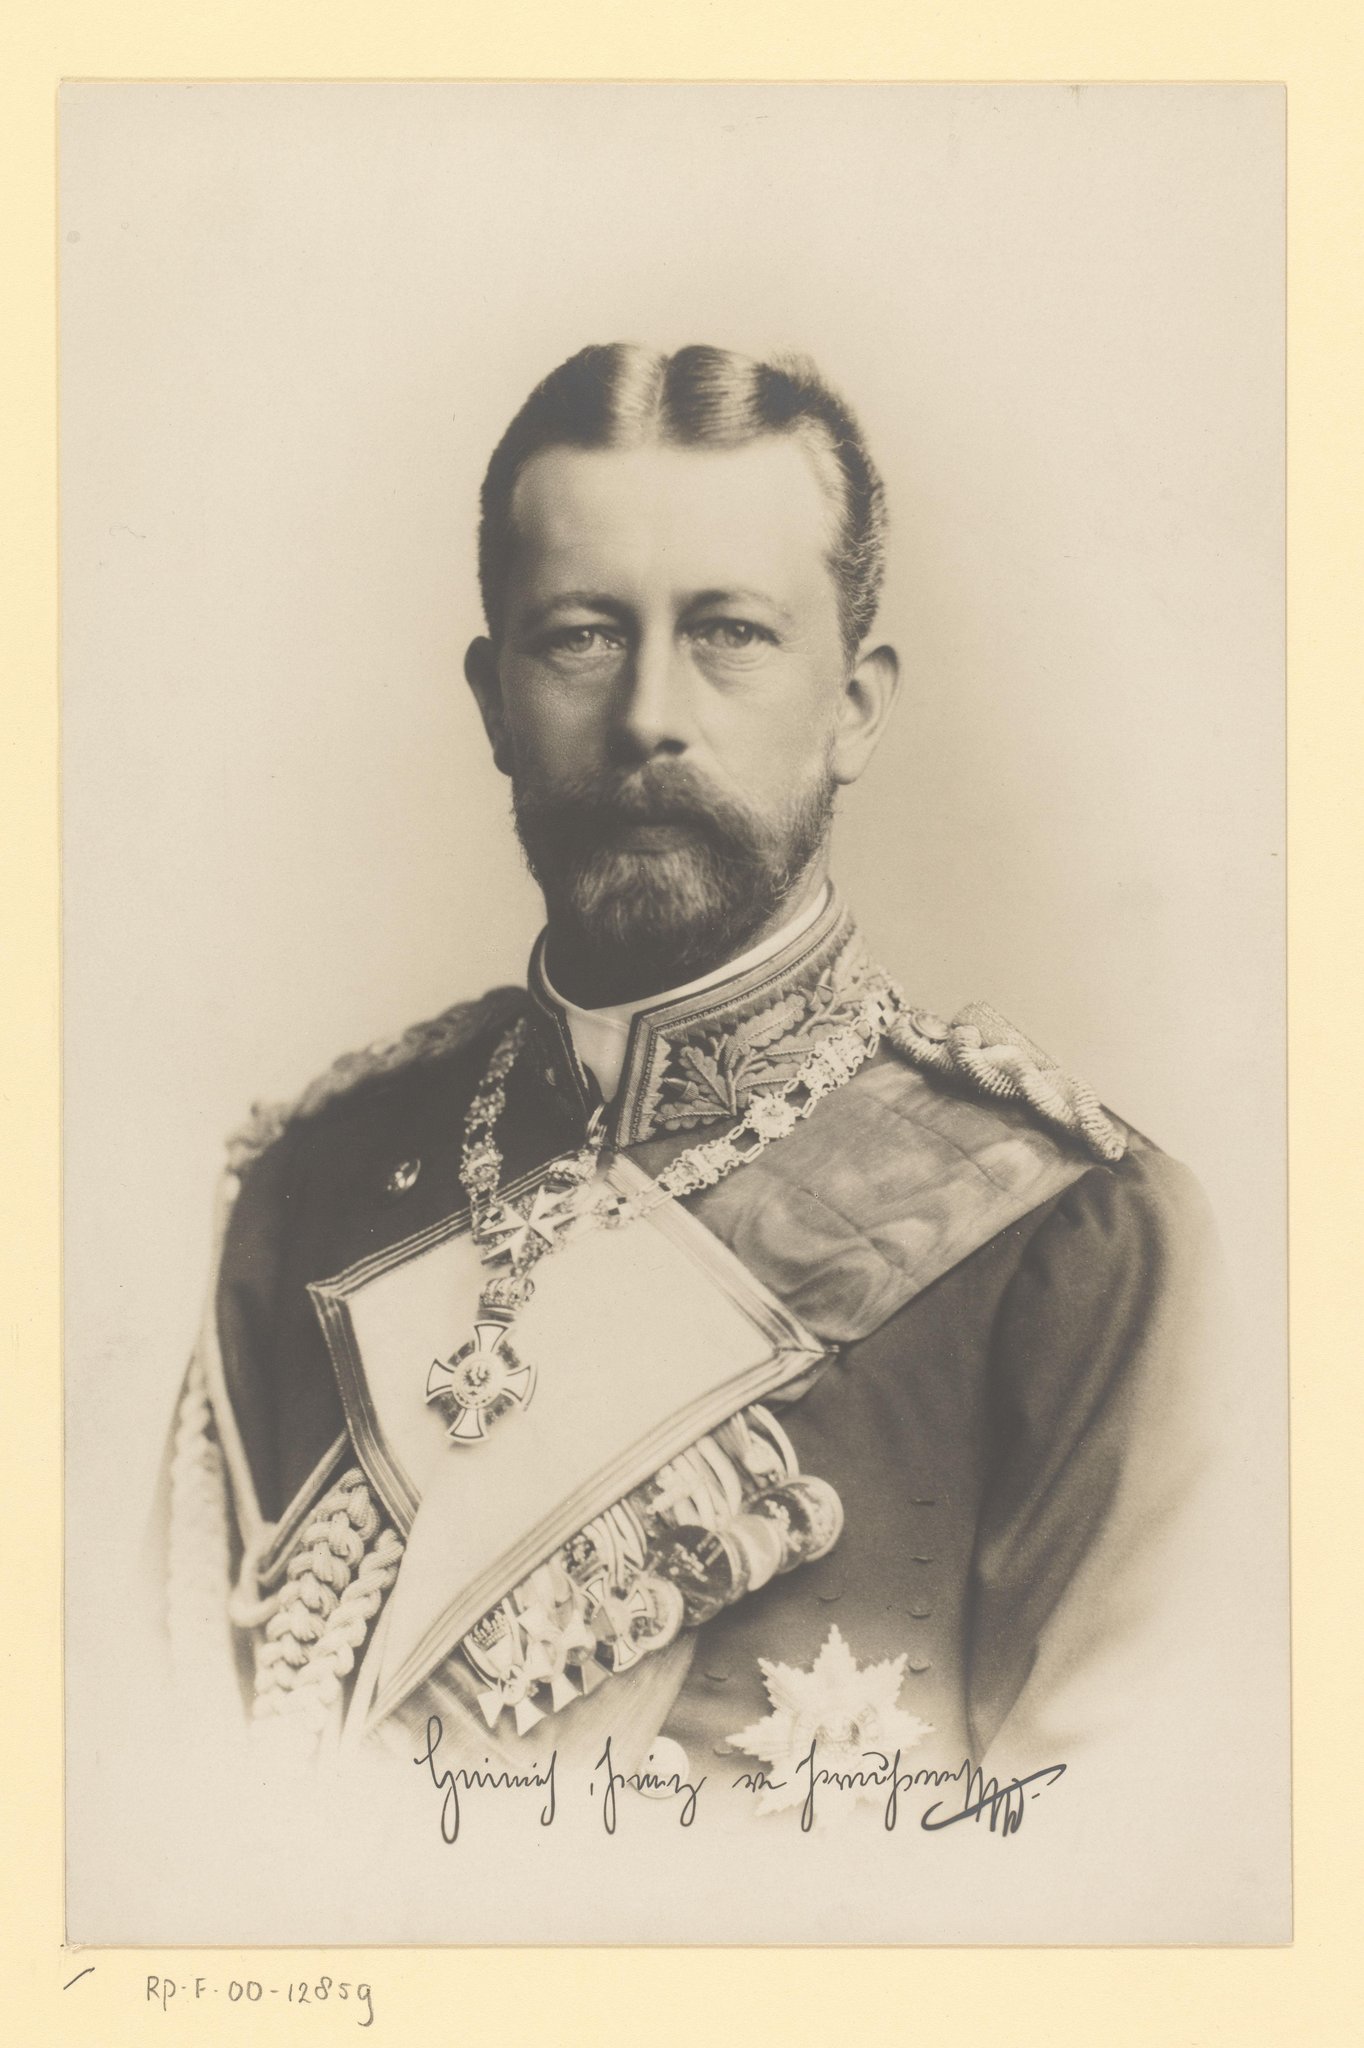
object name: photograph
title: Portret van Hendrik van Pruisen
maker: Anonymous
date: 1900-1915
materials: paper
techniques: gelatin silver print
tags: prince, historical persons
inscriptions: inscription: ‘Heinrich, Prinz von Preußen’